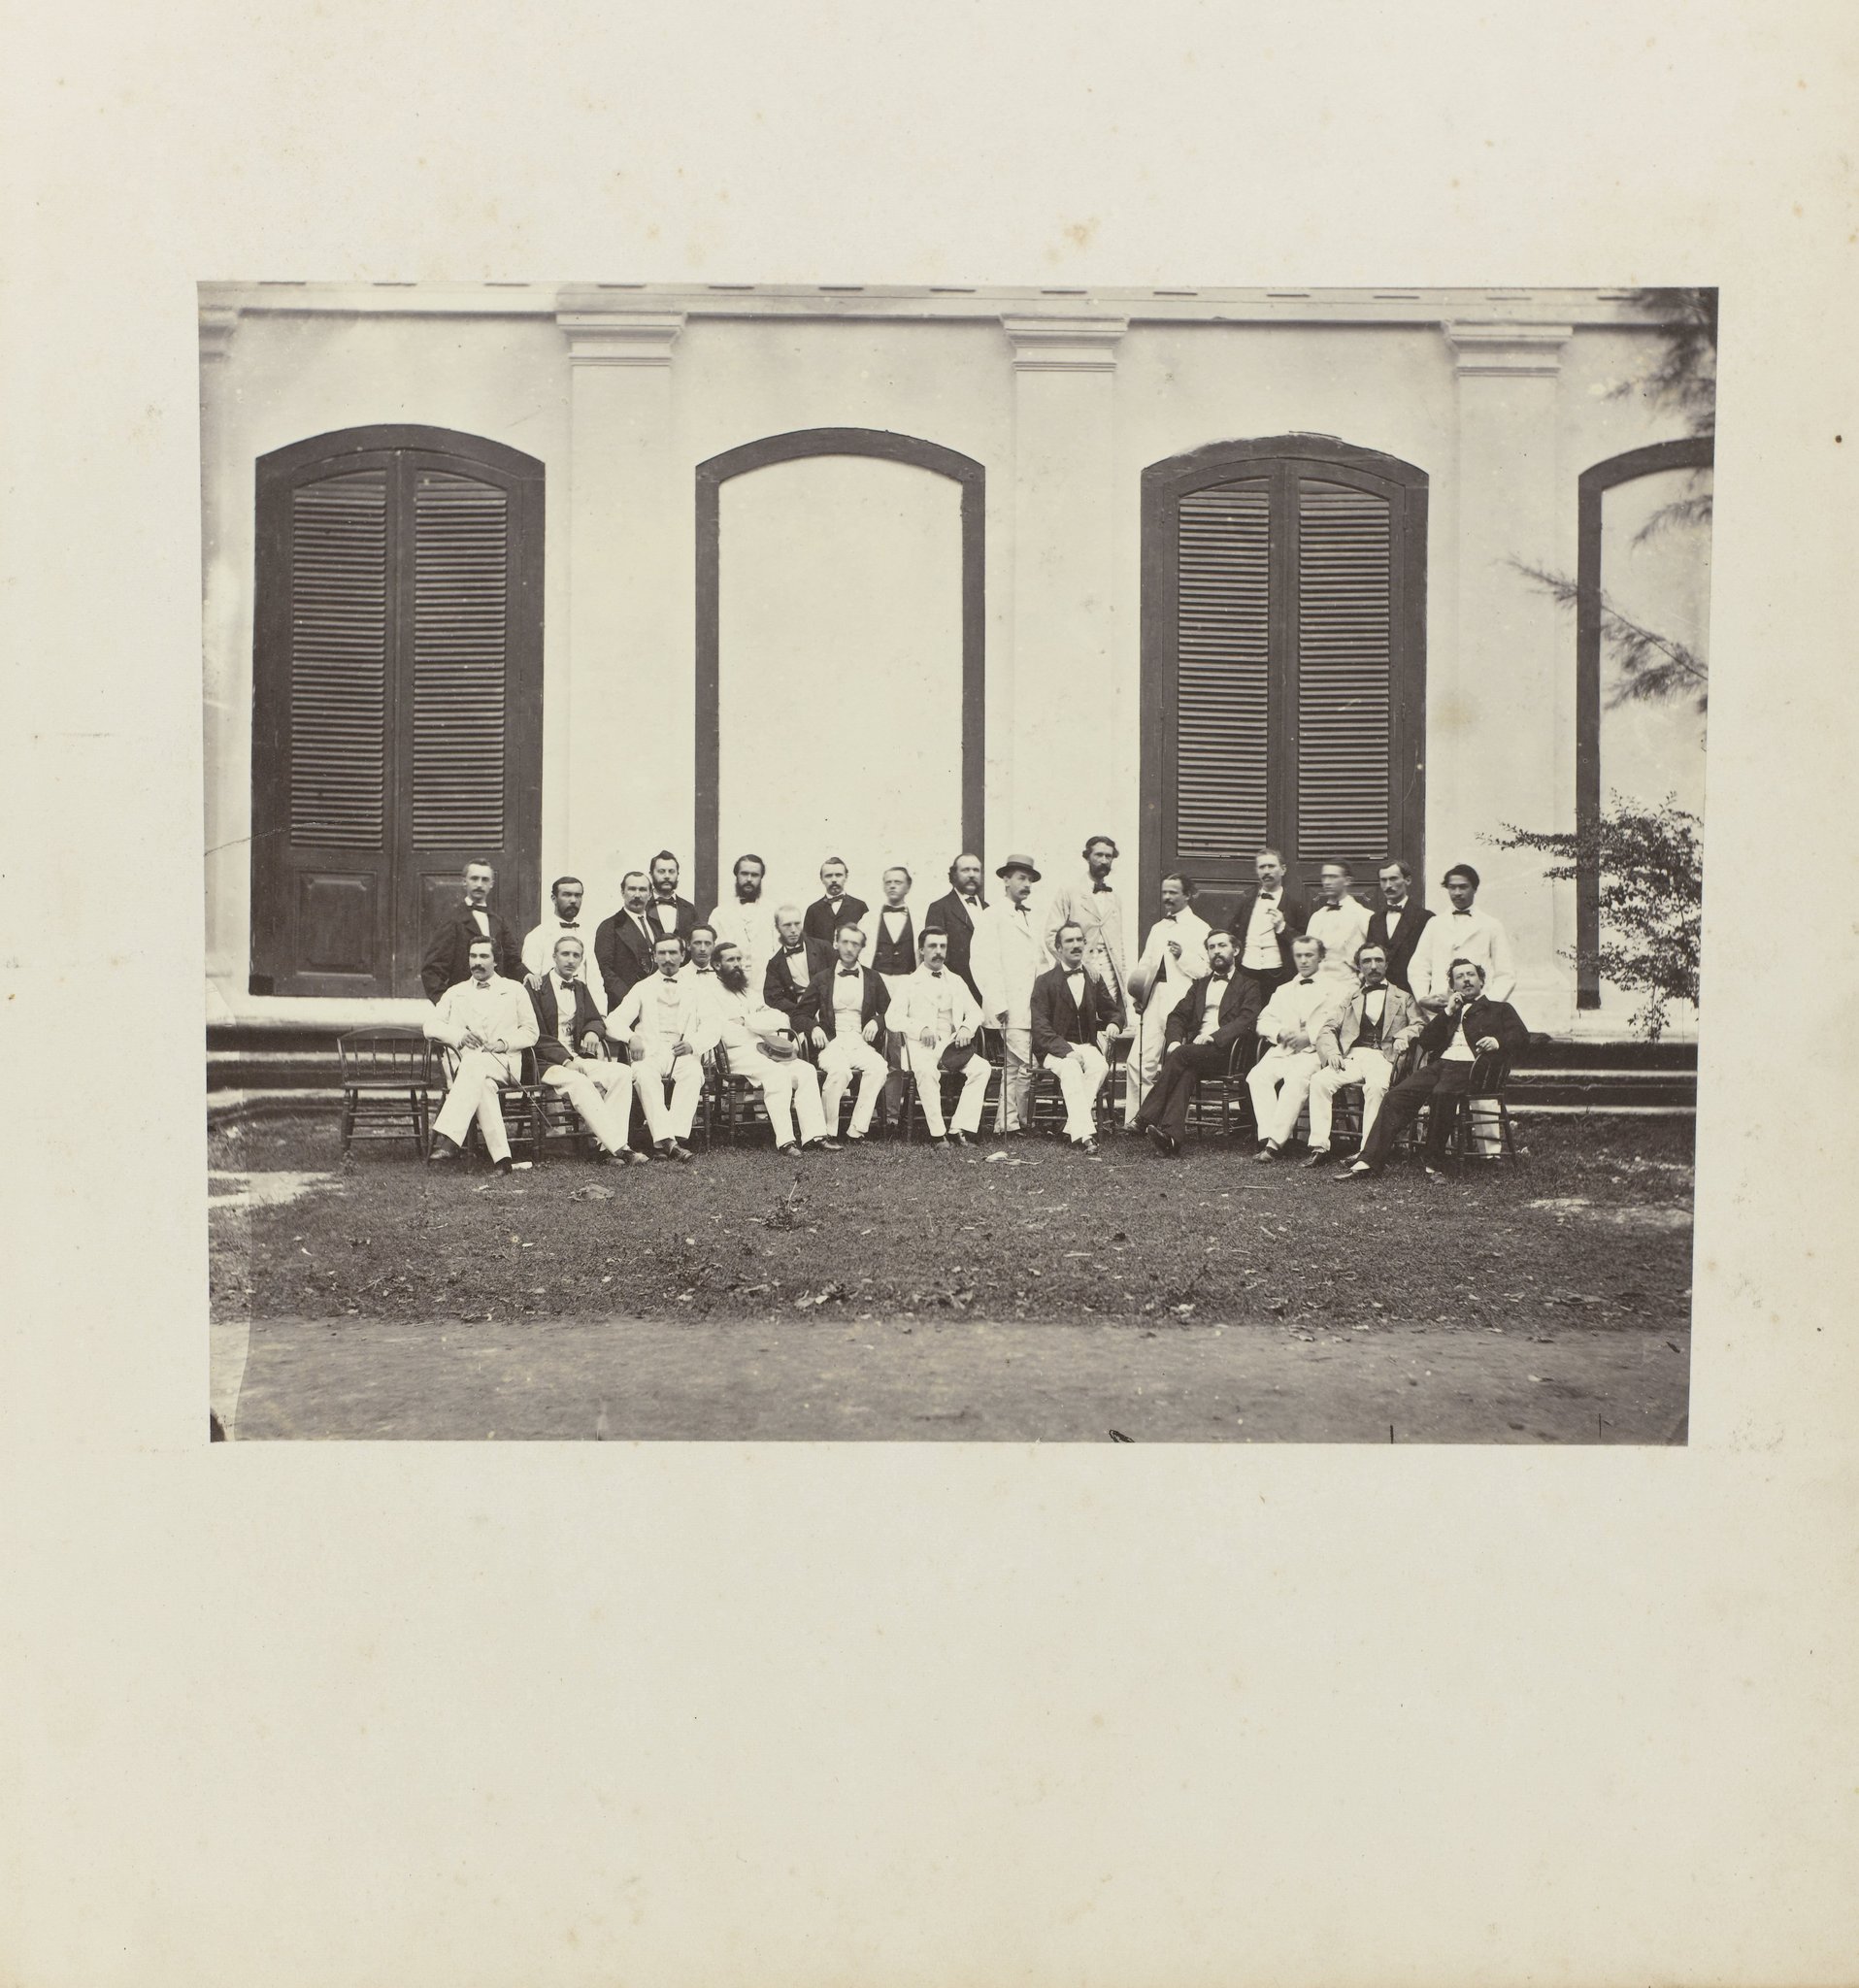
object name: photograph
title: Groepsfoto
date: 1863-1866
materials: photographic support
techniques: albumen print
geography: batavia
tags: club, meeting place, anonymous historical persons portrayed in a group, in a group-portrait, batavia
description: Een groep van 28 Europese mannnen zittend en staand poserend in een tuin bij Sociëteit de Harmonie in Batavia. Onderdeel van het rode fotoalbum met foto's van Java, uit het bezit van apotheker Specht-Grijp, die in 1865 vanuit Batavia naar Nederland terugkeerde.